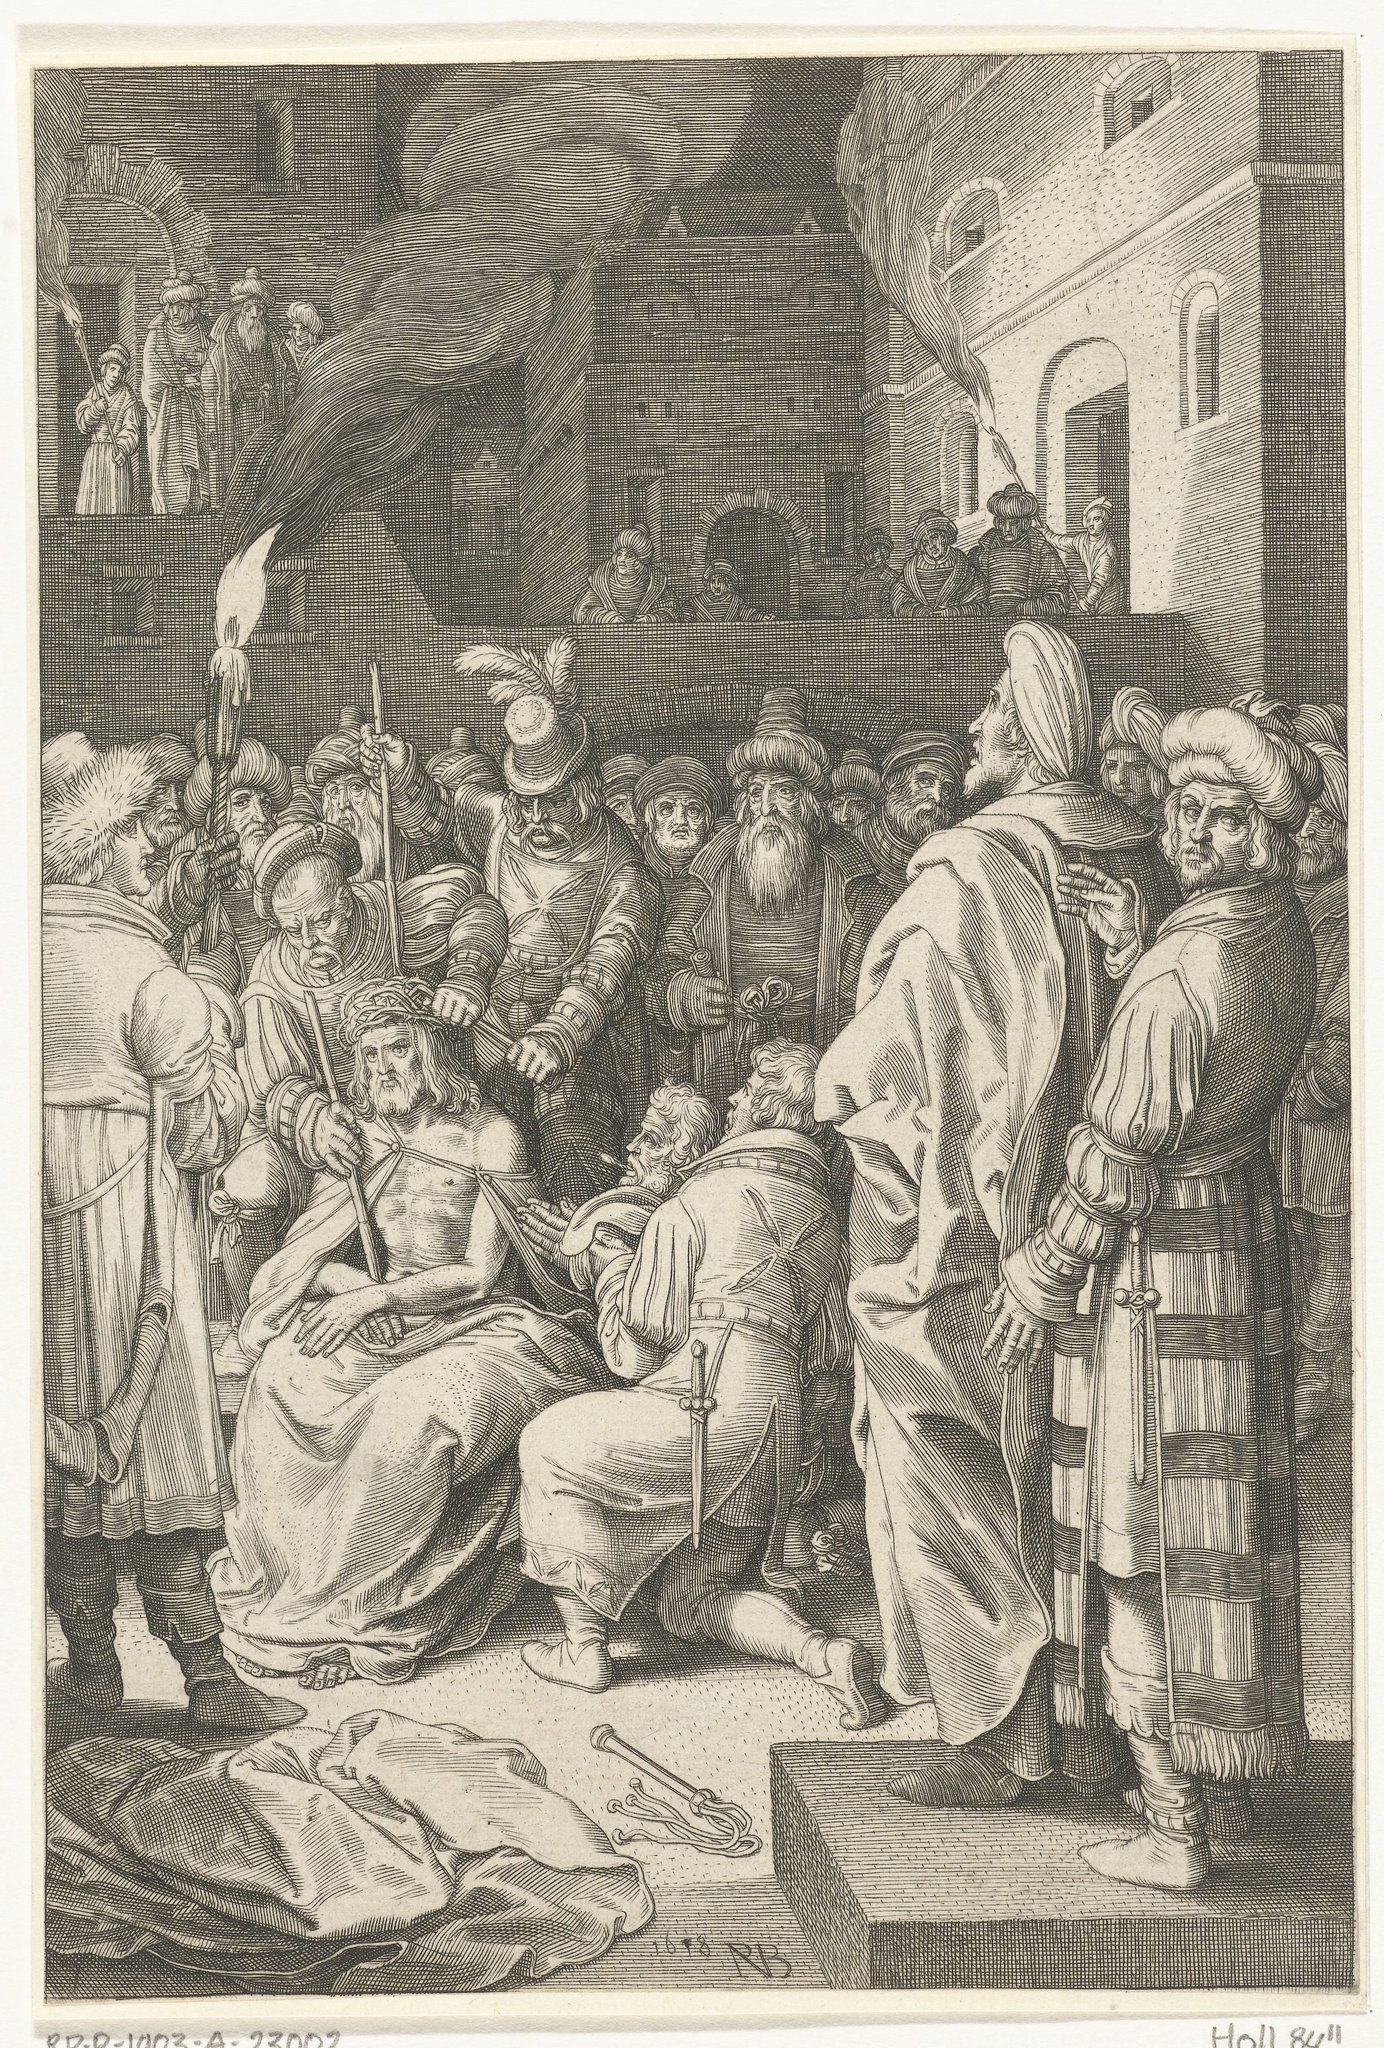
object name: print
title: De Passie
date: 1618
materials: paper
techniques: engraving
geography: netherlands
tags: the crowning with thorns: soldiers with sticks place a thorny crown on christ's head and give him a reed (matthew 27:27-31; mark 15:16-20; john 19:2-3)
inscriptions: collector's mark: Lugt 567, collector's mark: Lugt 2228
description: Christus zit tussen soldaten op het plein van het gerechtsgebouw van Pilatus. Hij draagt een mantel en krijgt een nep scepter in zijn hand, soldaten drukken de doornenkroon op zijn hoofd en omstanders reageren spottend door voor hem te knielen.